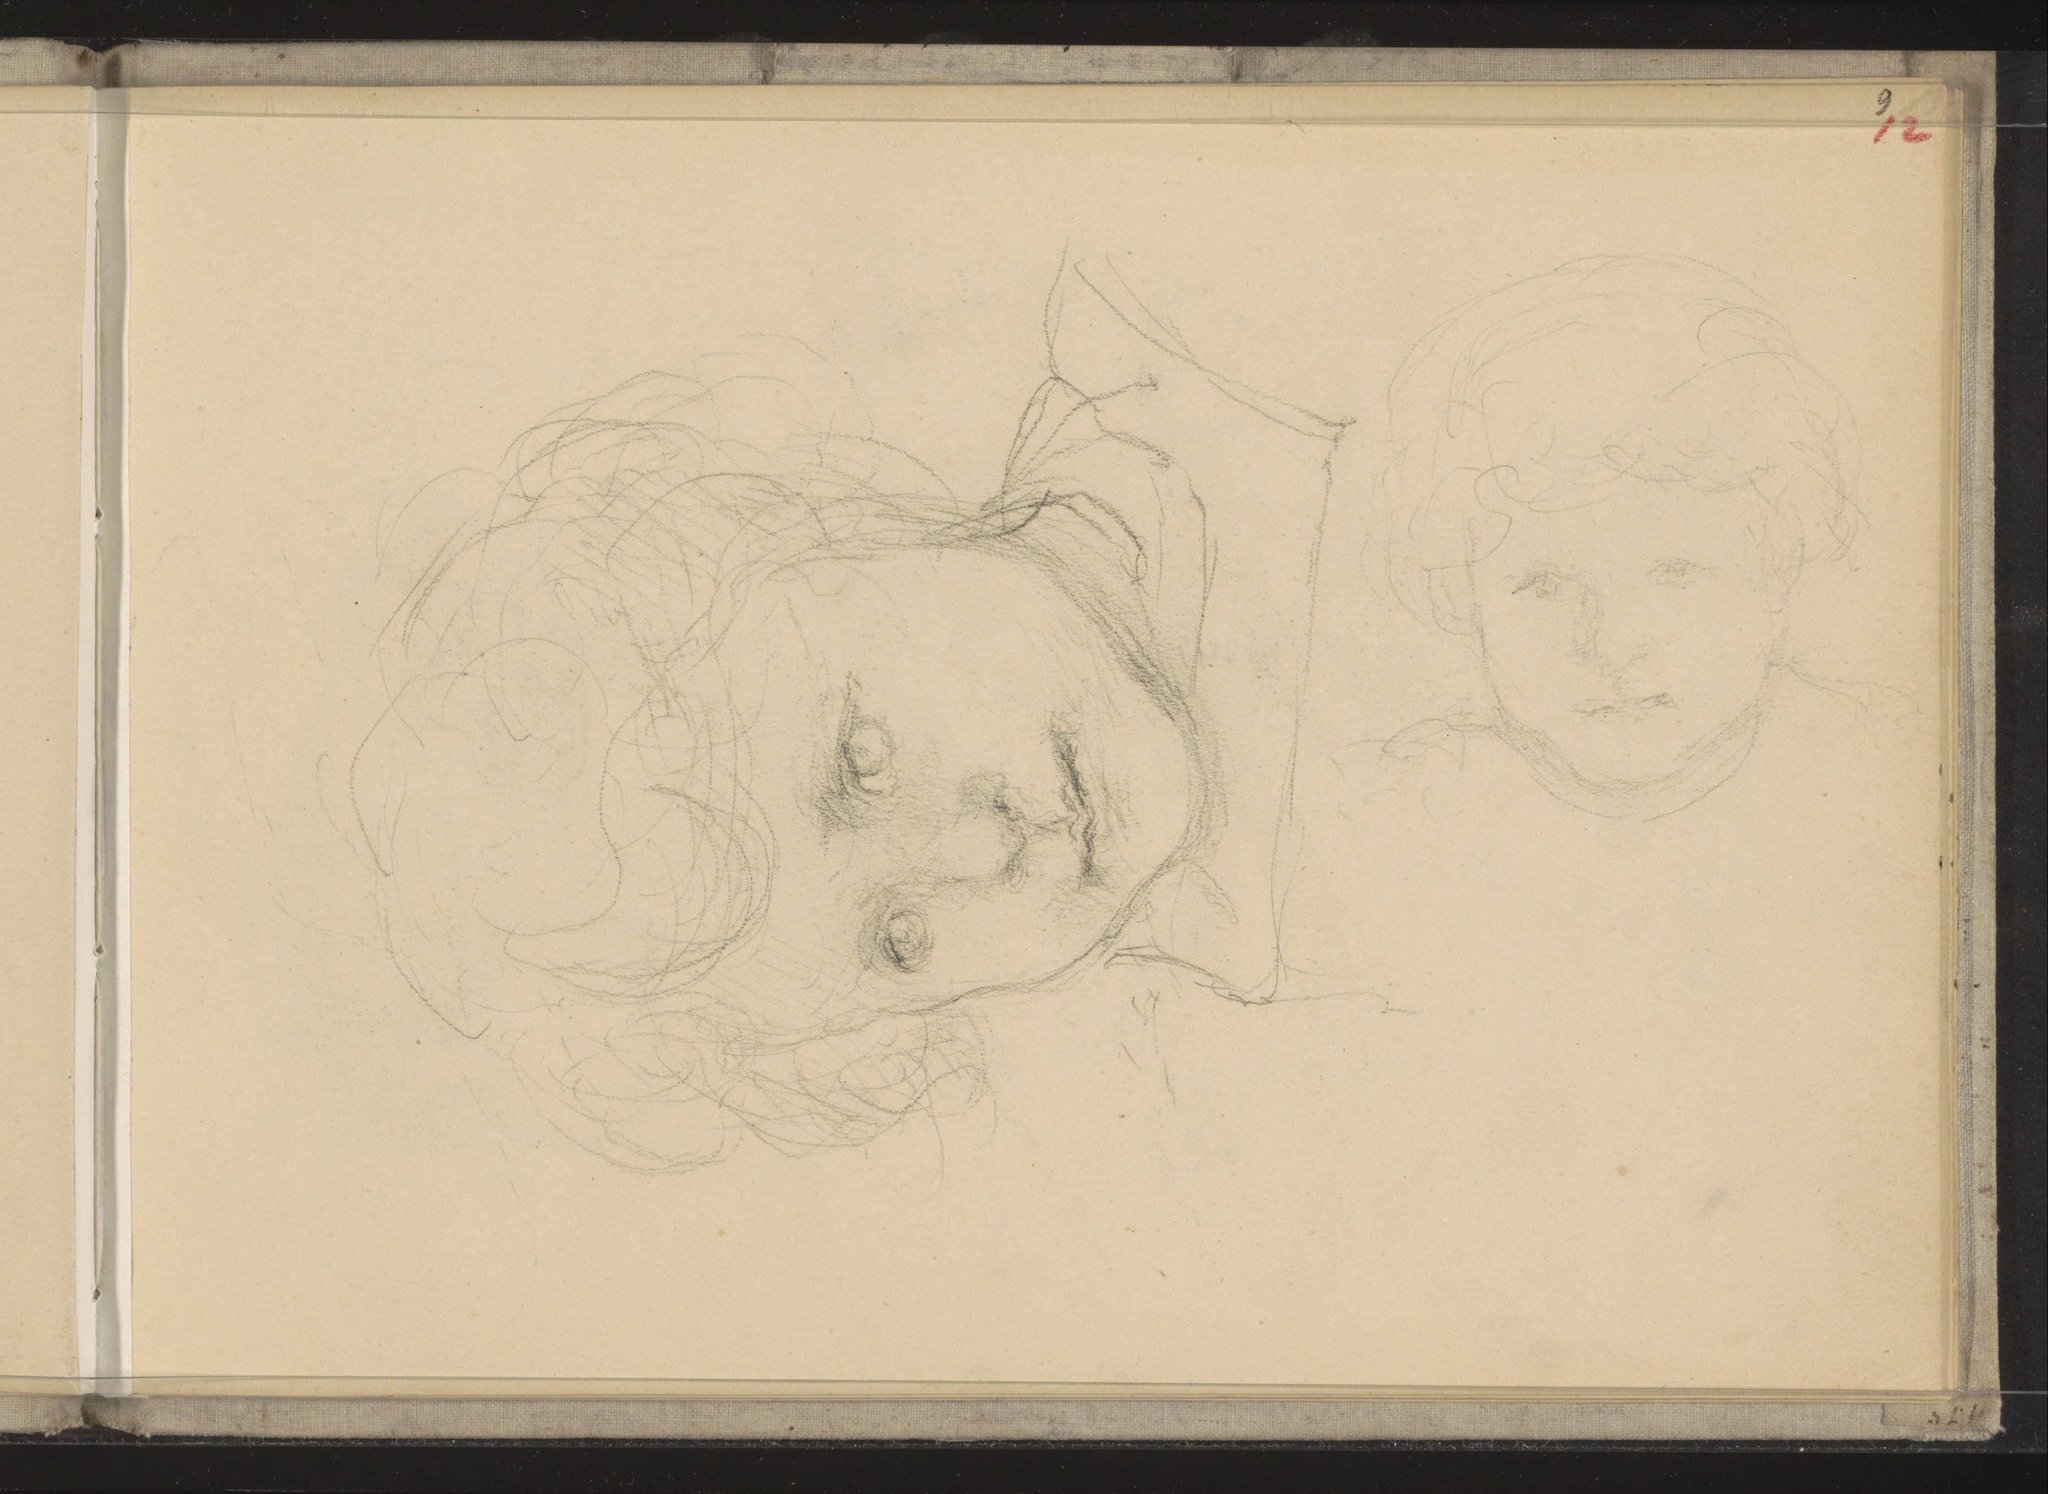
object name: sketchbook leaf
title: Koppen van een kind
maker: jozef israëls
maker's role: draughtsman, painter, print maker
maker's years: 1824-1911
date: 1834-1911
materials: paper, pencil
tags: head (human)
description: Blad 9 recto uit een schetsboek met 18 bladen.